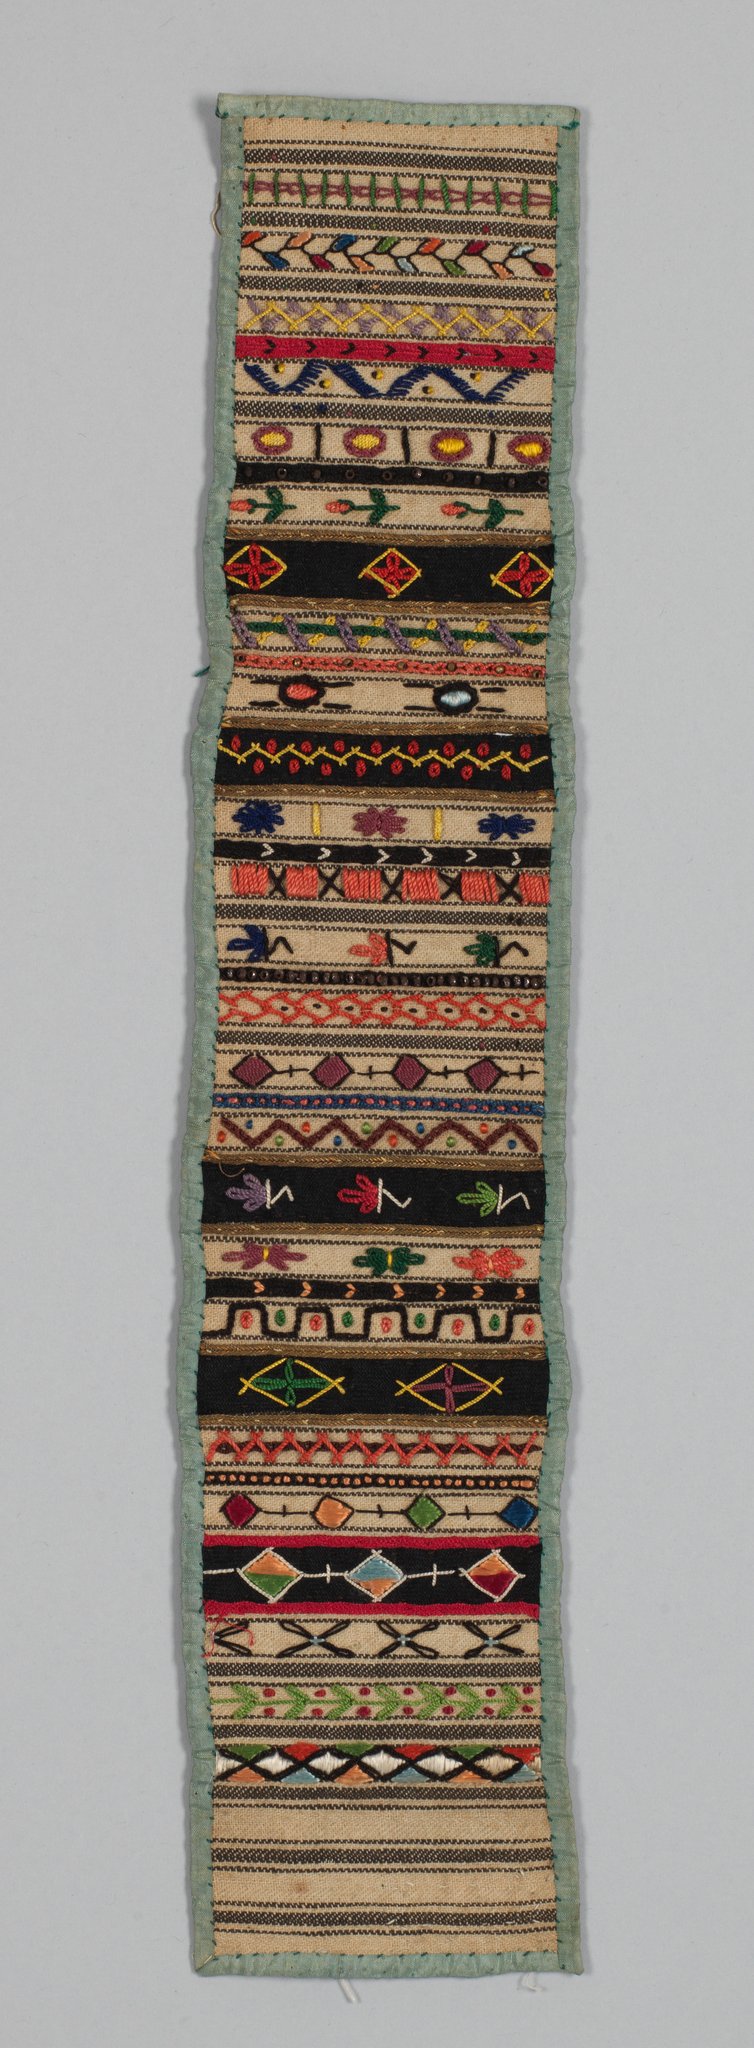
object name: sampler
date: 1801-1900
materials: cotton, silk